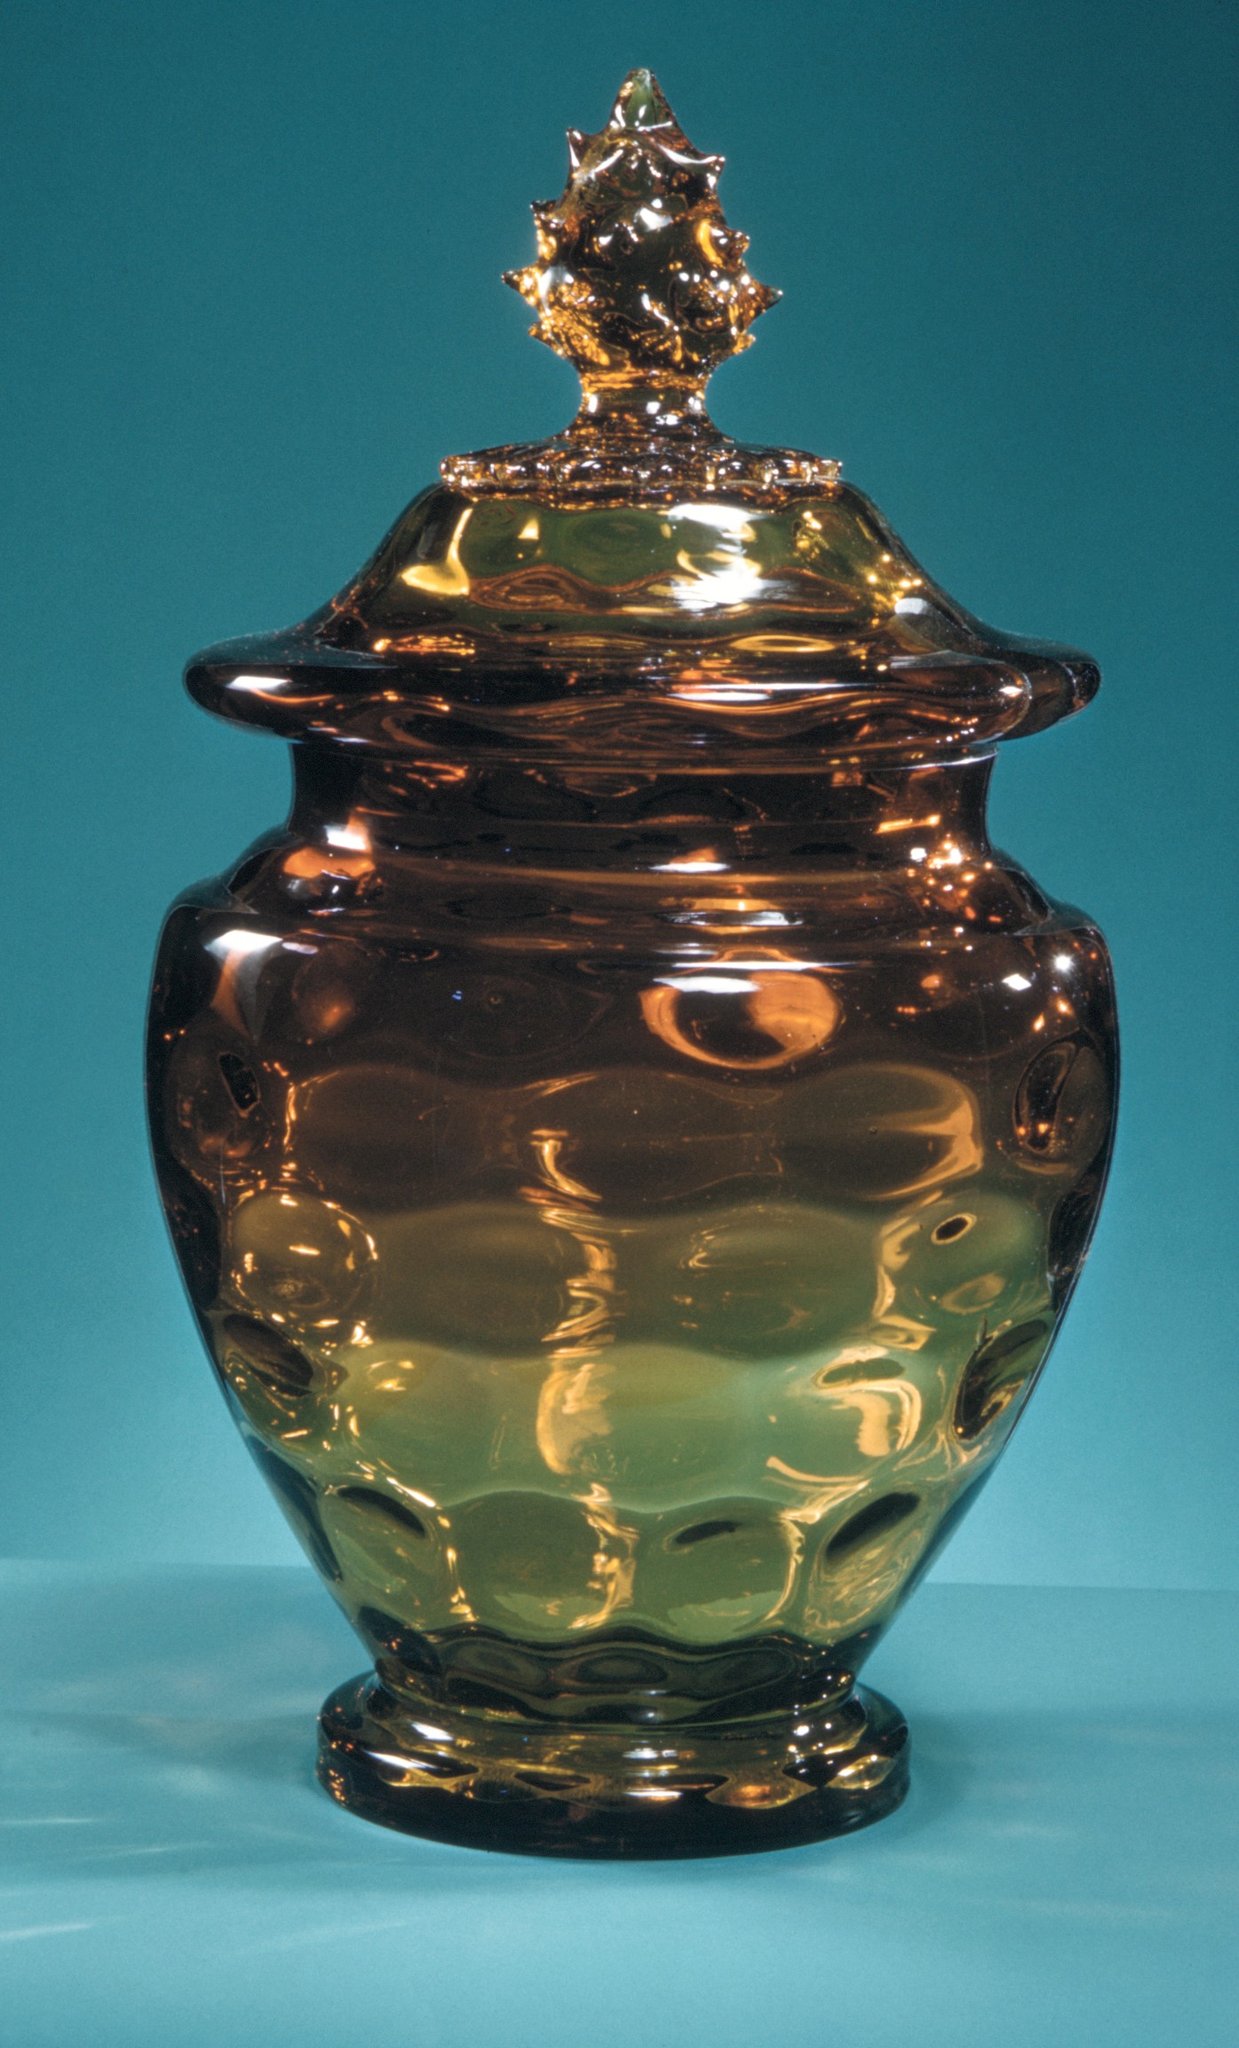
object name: punch bowl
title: Covered Punch Bowl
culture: american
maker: hobbs, brockunier and company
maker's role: maker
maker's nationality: american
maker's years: 1863-1891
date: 1885-1887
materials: glass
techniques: glassblowing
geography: united states